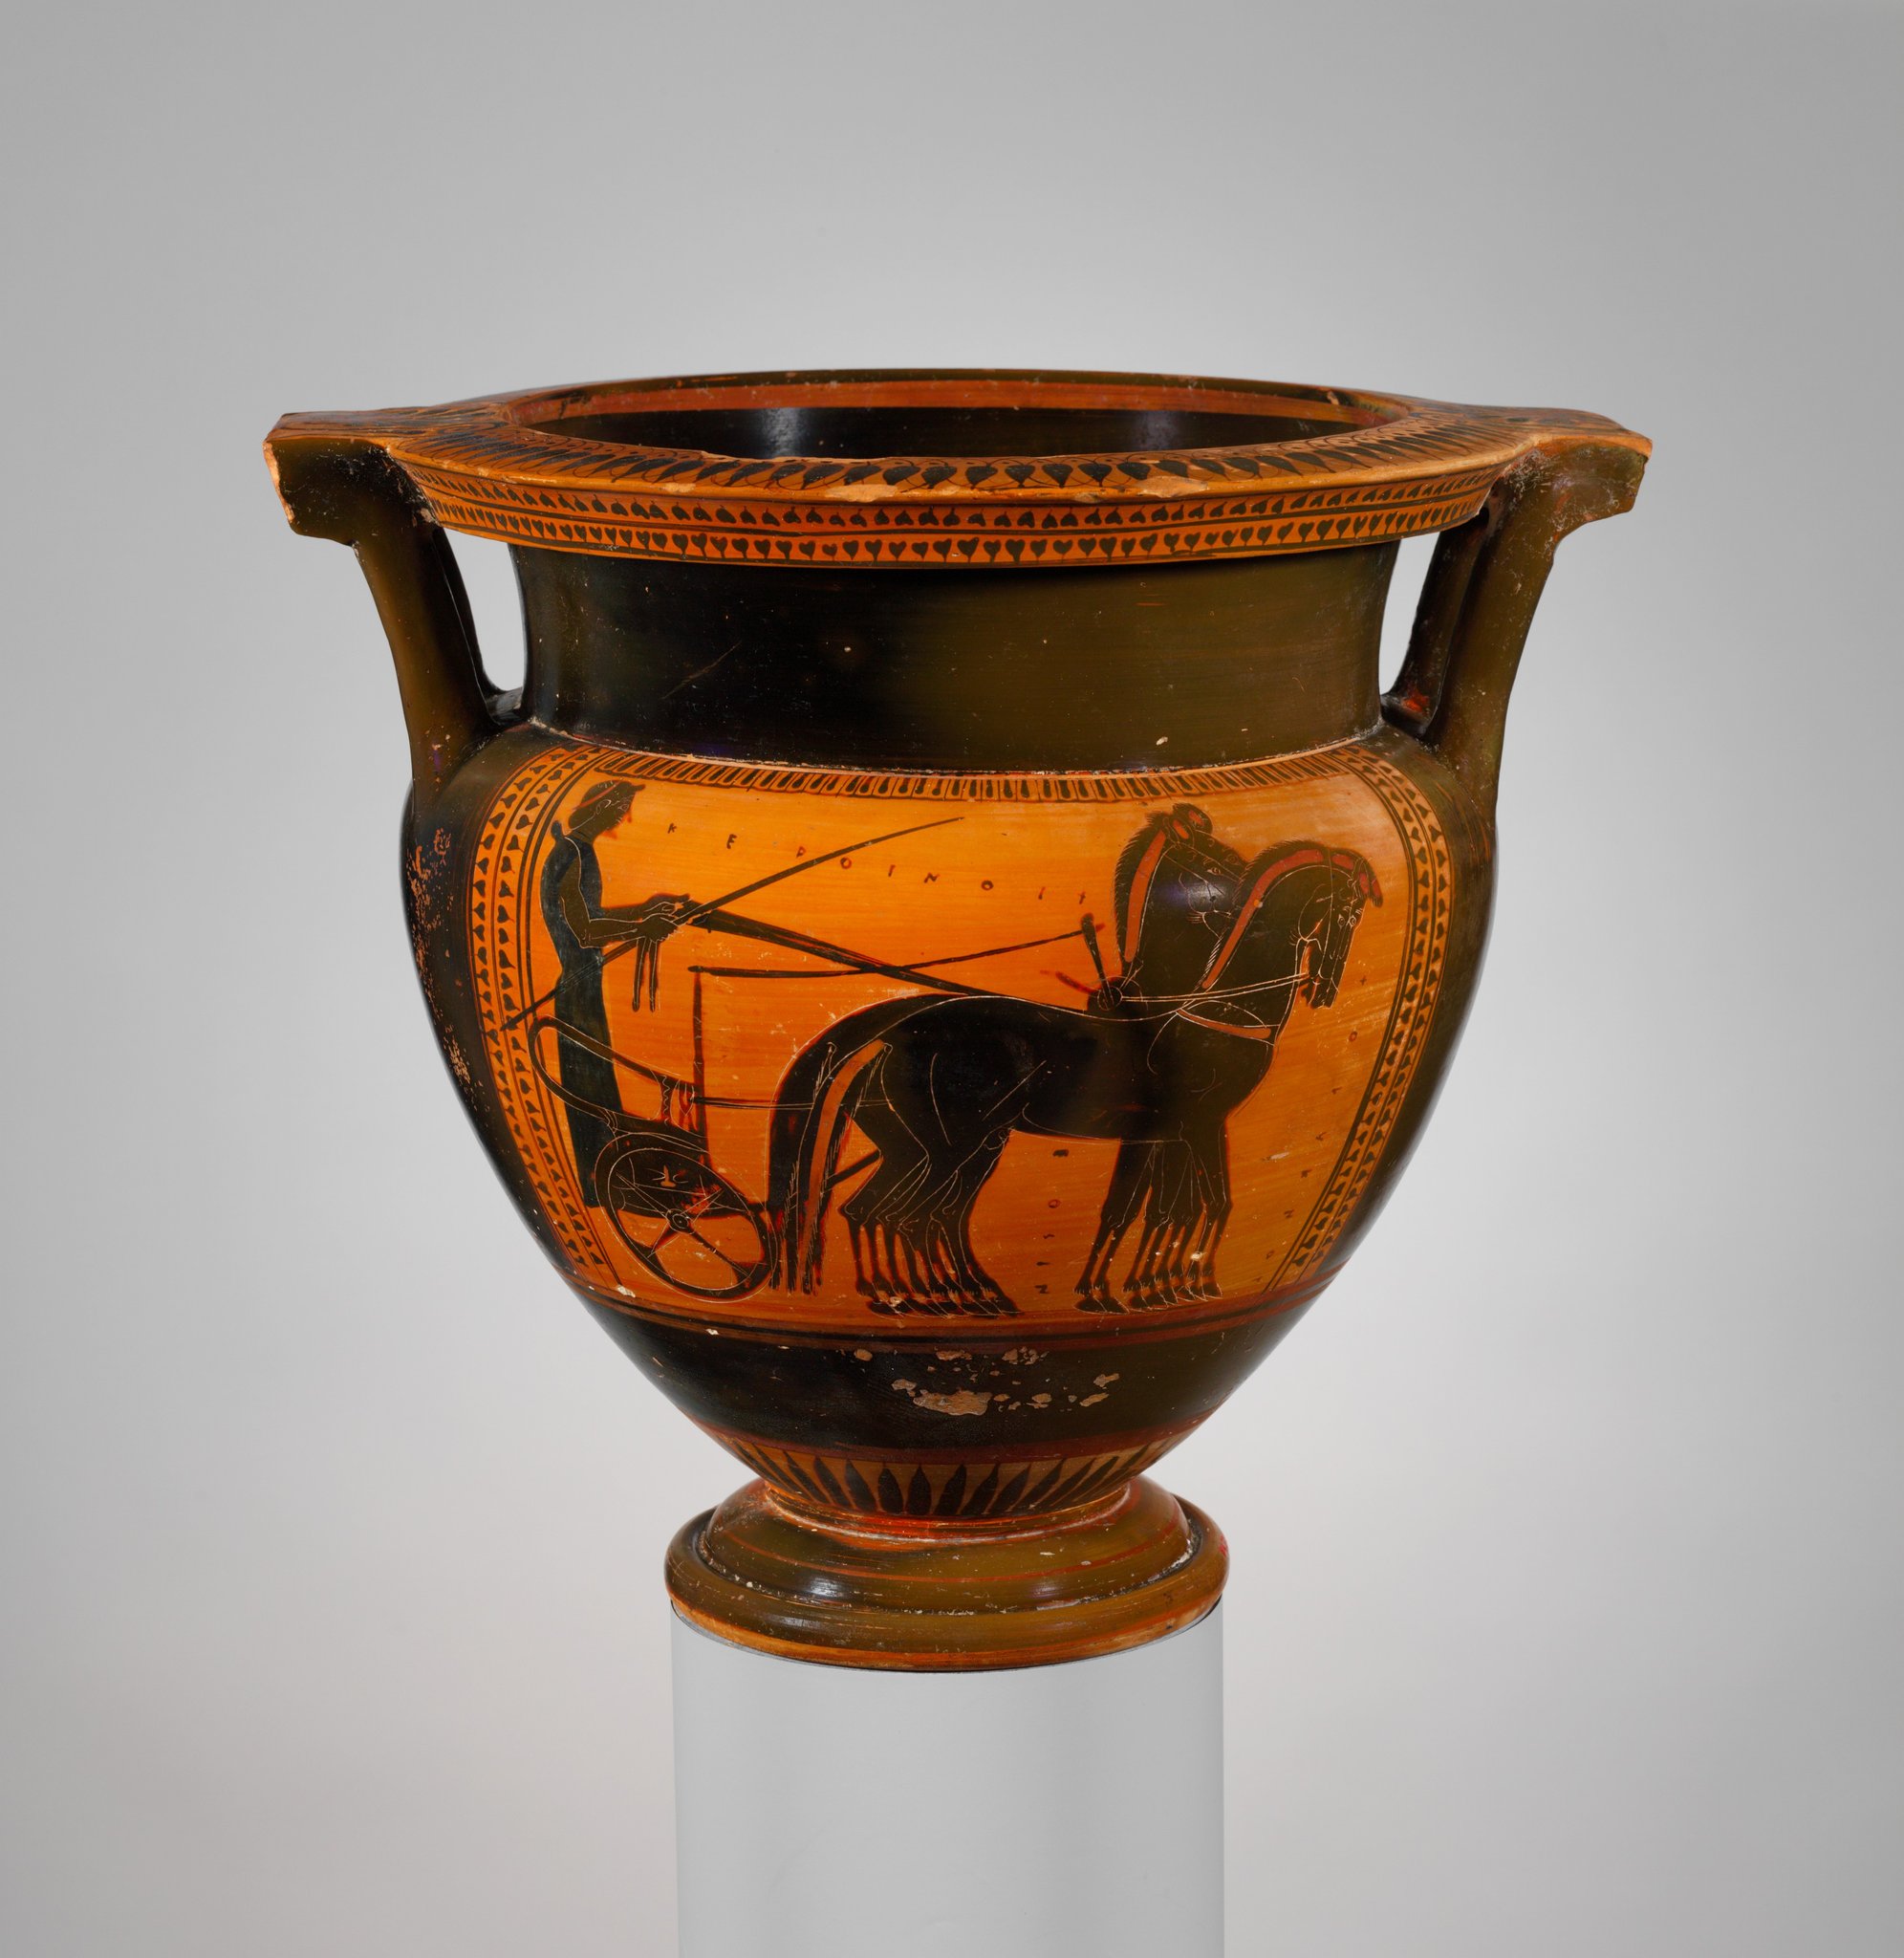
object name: column krater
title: Terracotta column-krater (bowl for mixing wine and water)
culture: greek, attic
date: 525-501 BCE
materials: terracotta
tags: men,horses,chariots